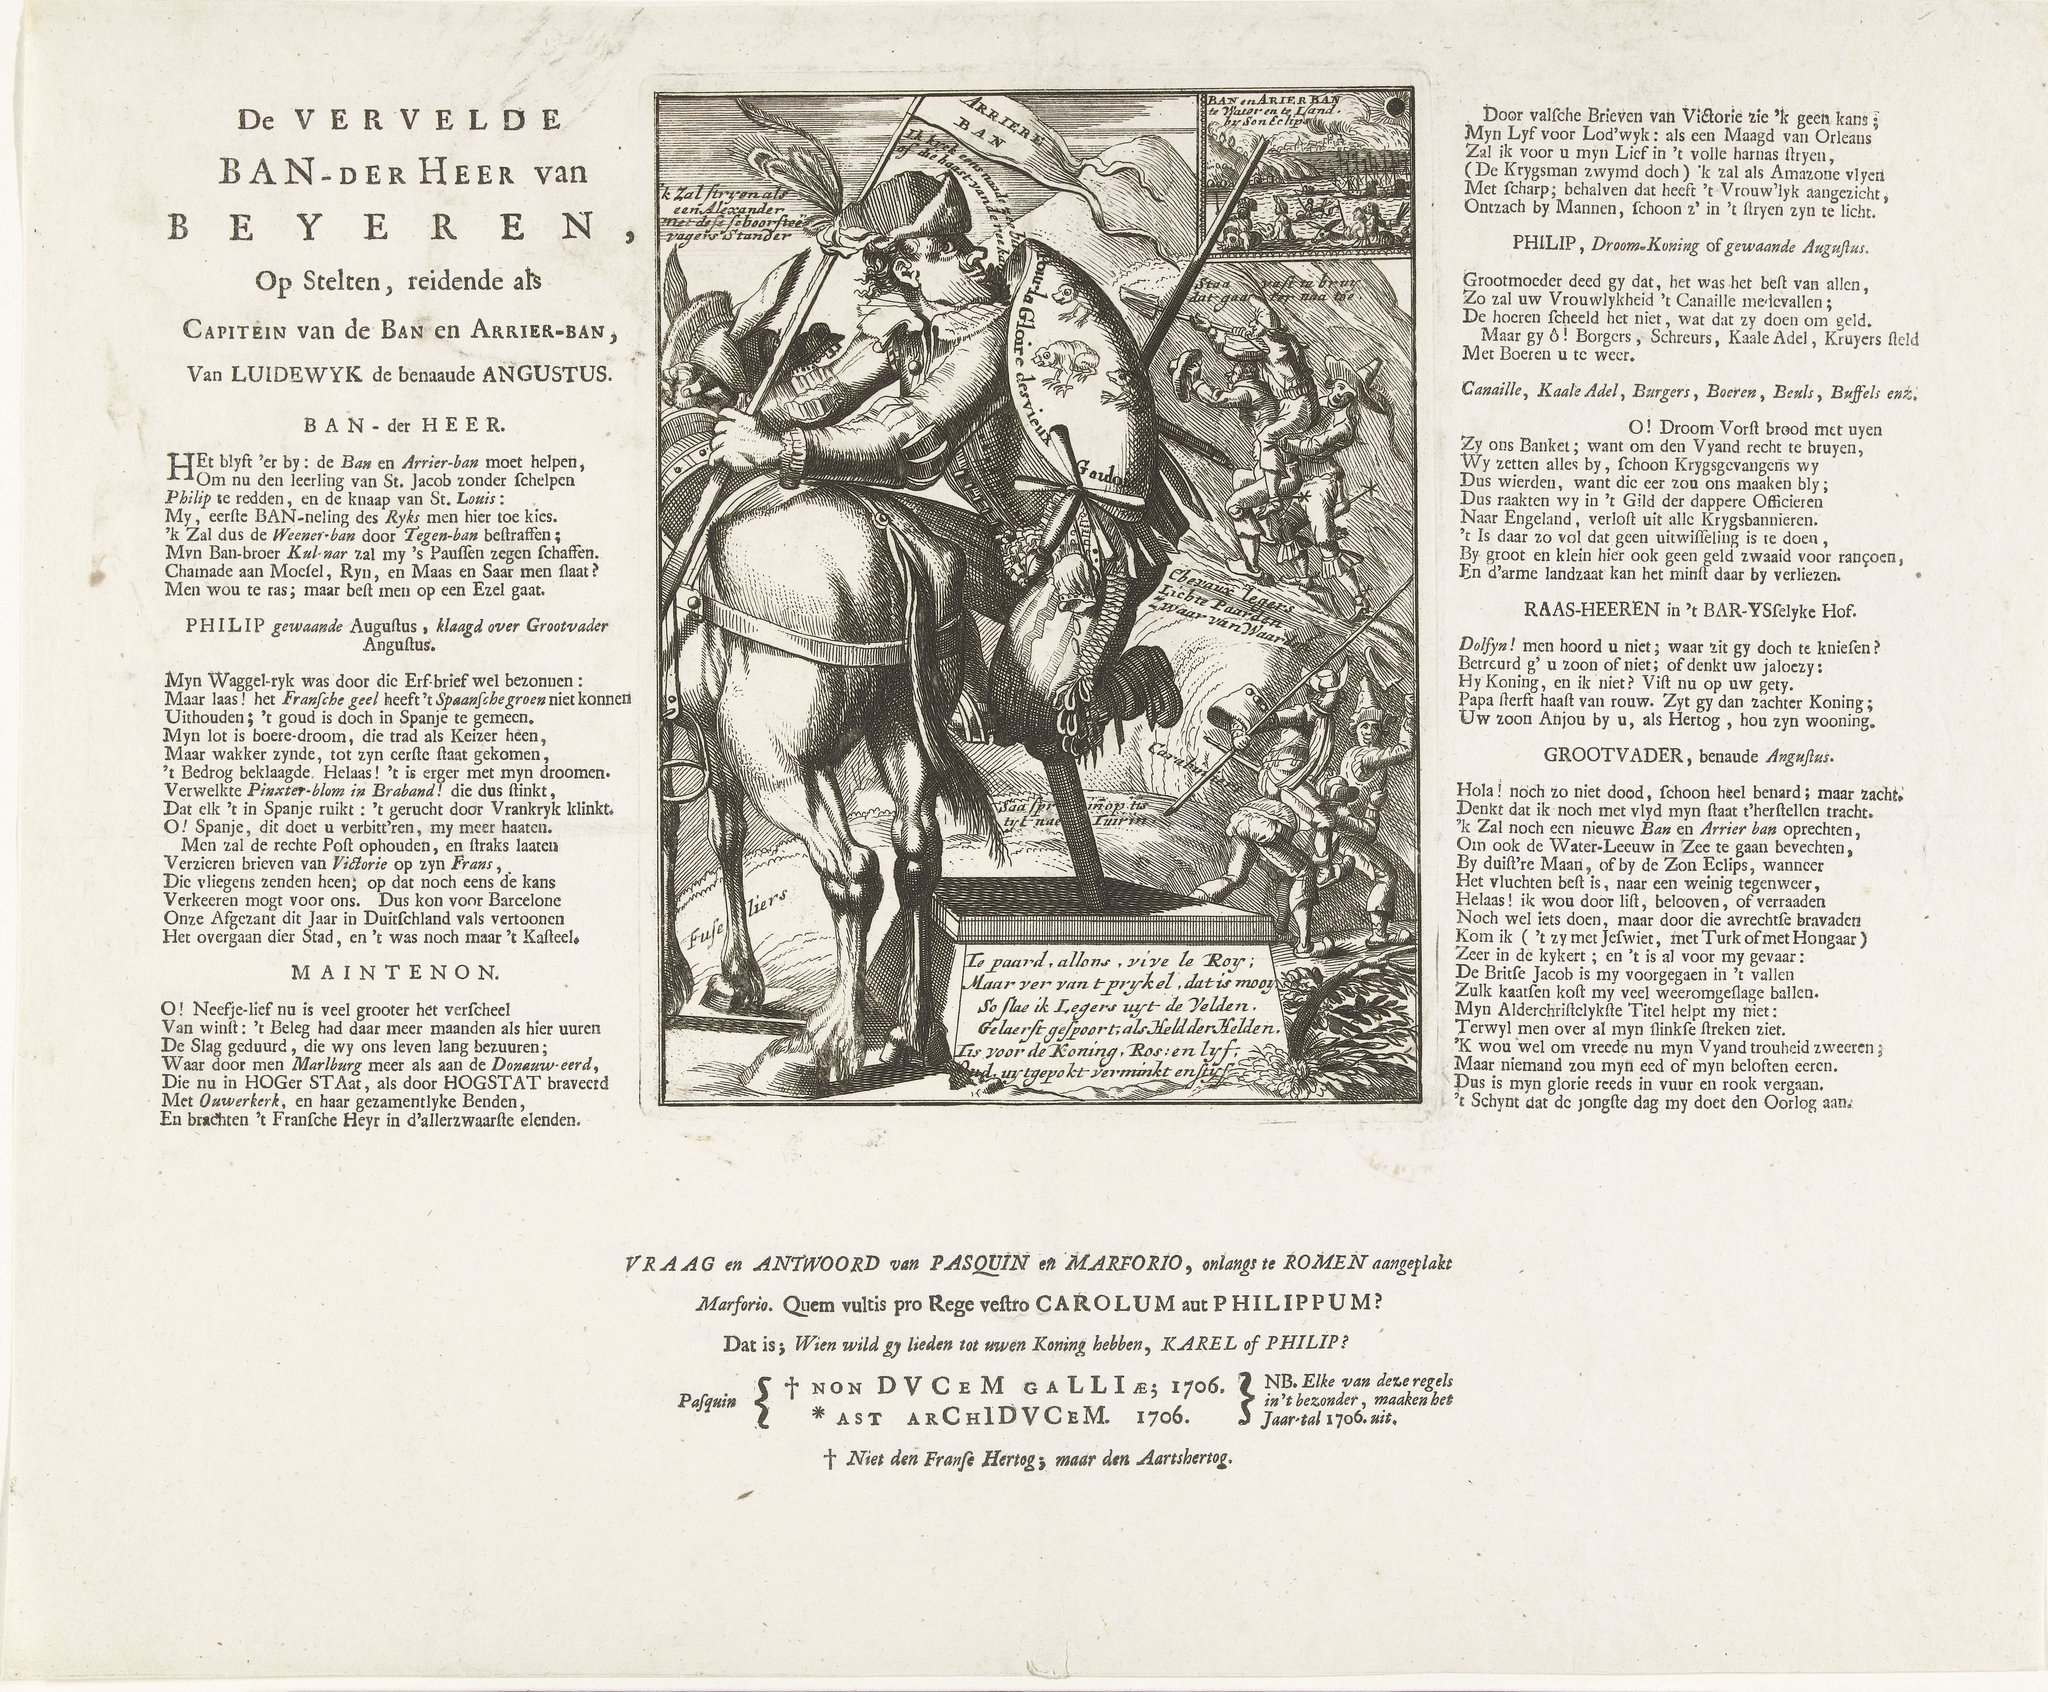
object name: cartoon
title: Koninklijke Almanach van 1701 / 't Lusthof van Momus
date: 1706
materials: paper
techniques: etching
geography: northern netherlands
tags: maximiliaan ii emanuel (keurvorst van beieren), crutches, political caricatures and satires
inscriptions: collector's mark: Lugt 240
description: Spotprent op Maximiliaan II Emanuel, keurvorst van Beieren als een onbekwame ruiter met een houten been die op een paard klimt. Onder en aan weerszijden van de plaat een vers in het Nederlands. Onderdeel van een reeks van 19 spotprenten op de Fransen en bondgenoten uit het jaar 1706.